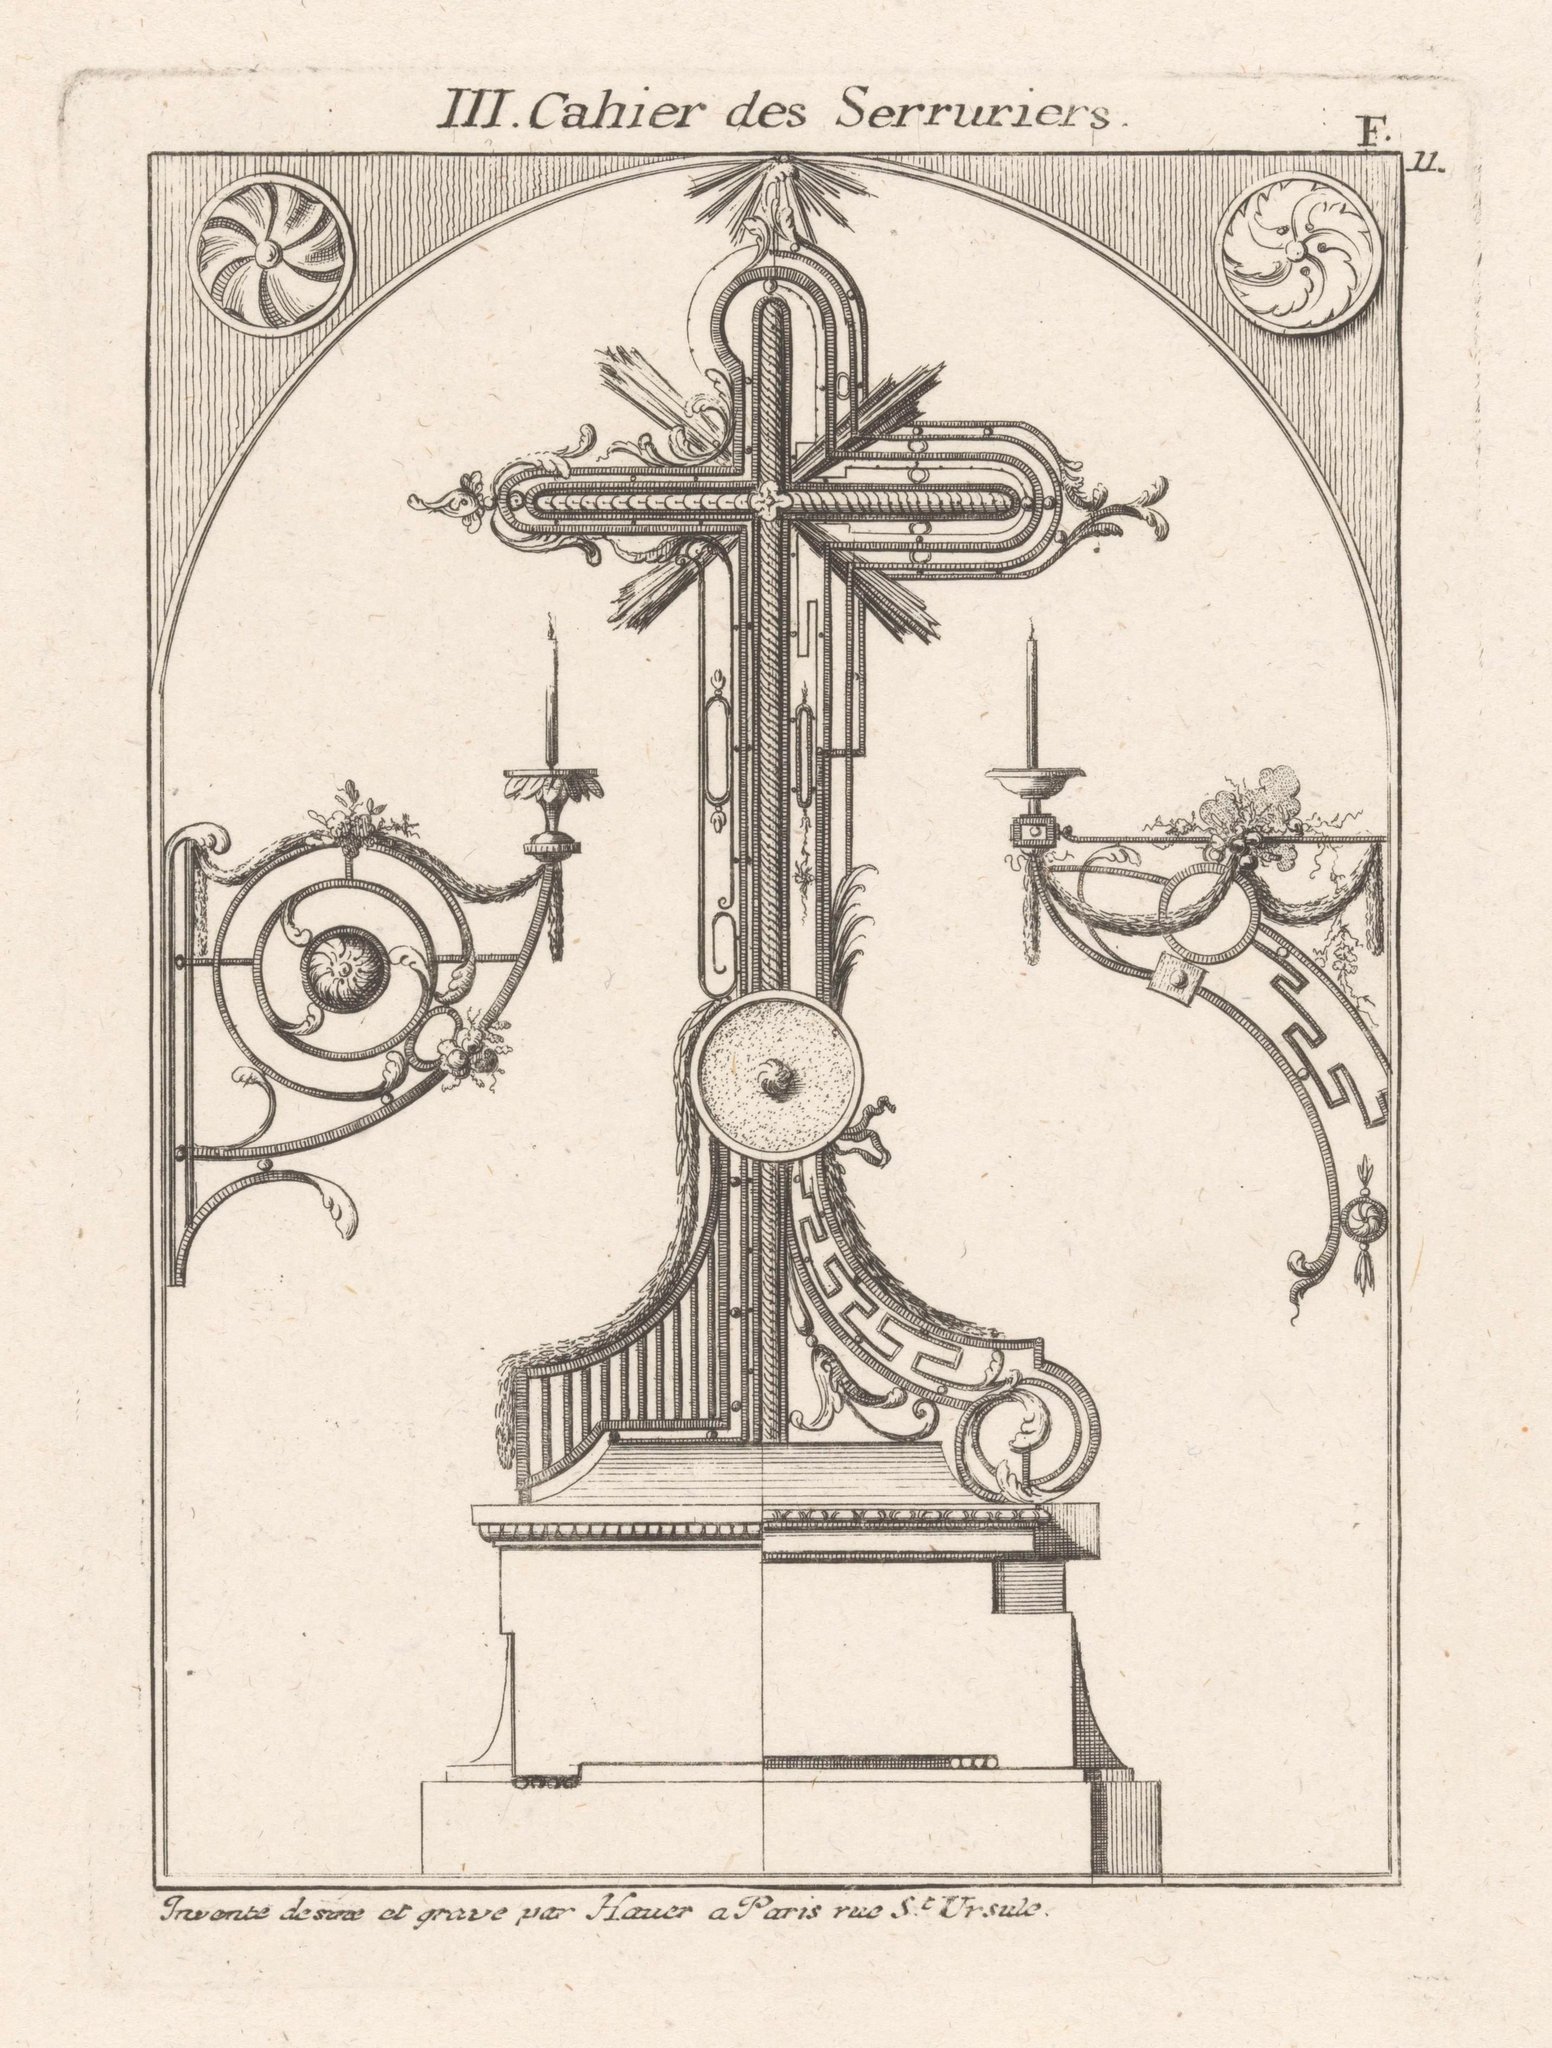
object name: print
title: III Cahier des Serruriers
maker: johann thomas hauer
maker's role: print maker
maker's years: 1748-1820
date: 1781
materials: paper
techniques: etching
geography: paris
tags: forging (industrial process)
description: Ontwerpen voor smeedwerk in de vorm van een kruis en twee wandkandelaars met guirlandes en bloemmotieven.